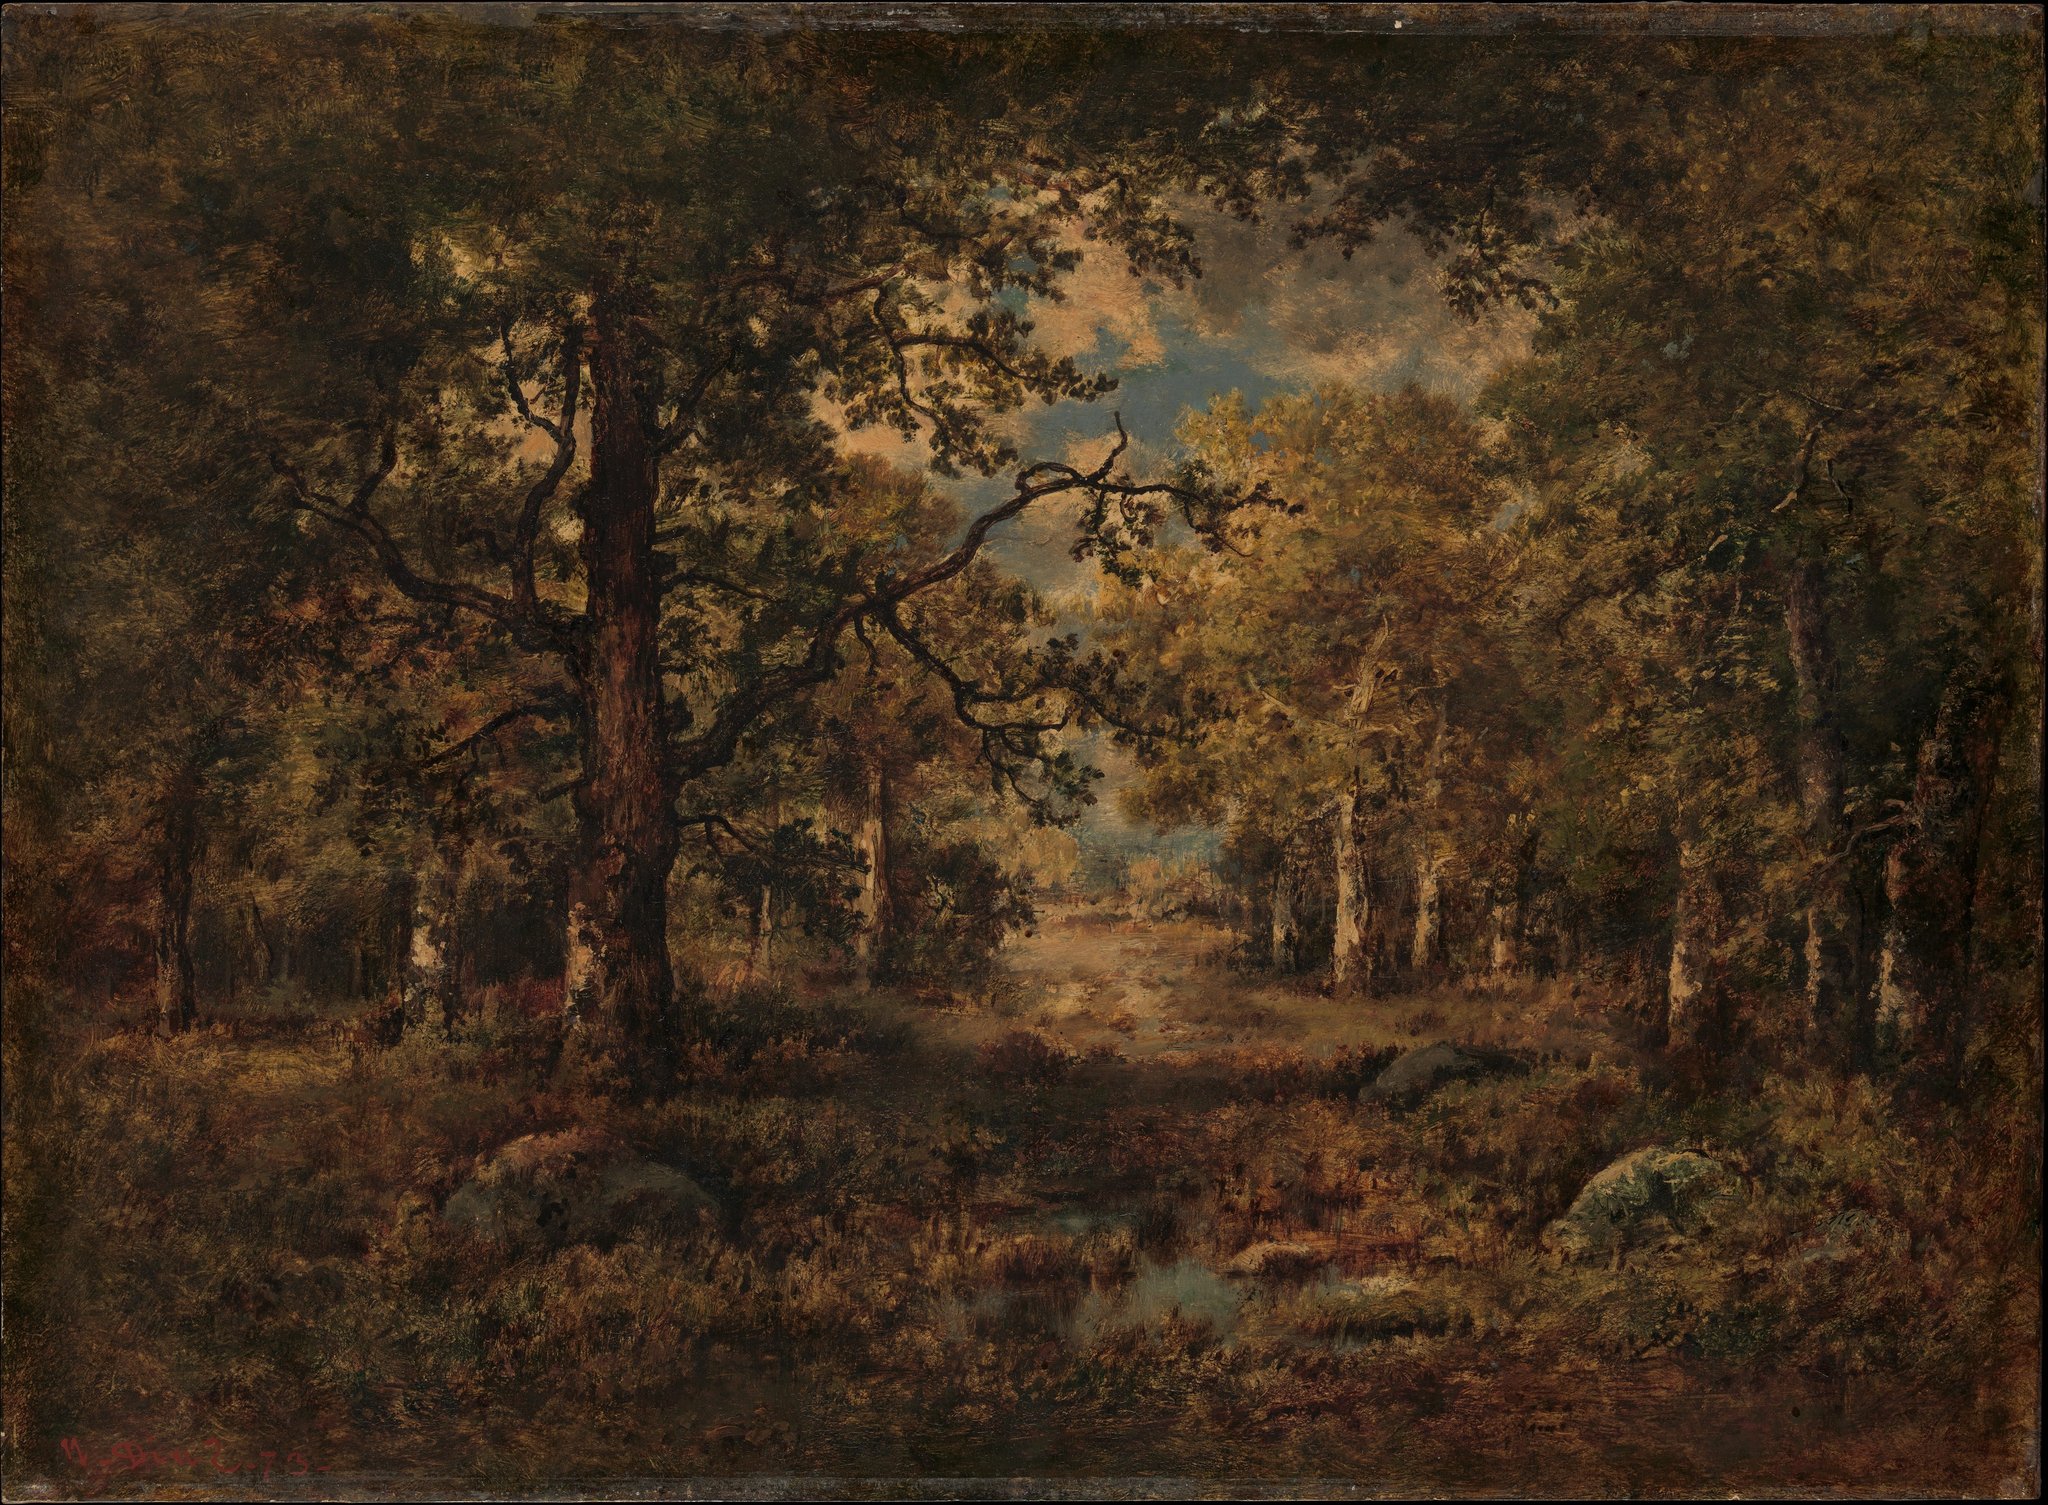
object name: painting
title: A Vista through Trees: Fontainebleau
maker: narcisse-virgile diaz de la peña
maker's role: artist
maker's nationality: french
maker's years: 1808-1876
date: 1873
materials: oil, wood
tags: forests